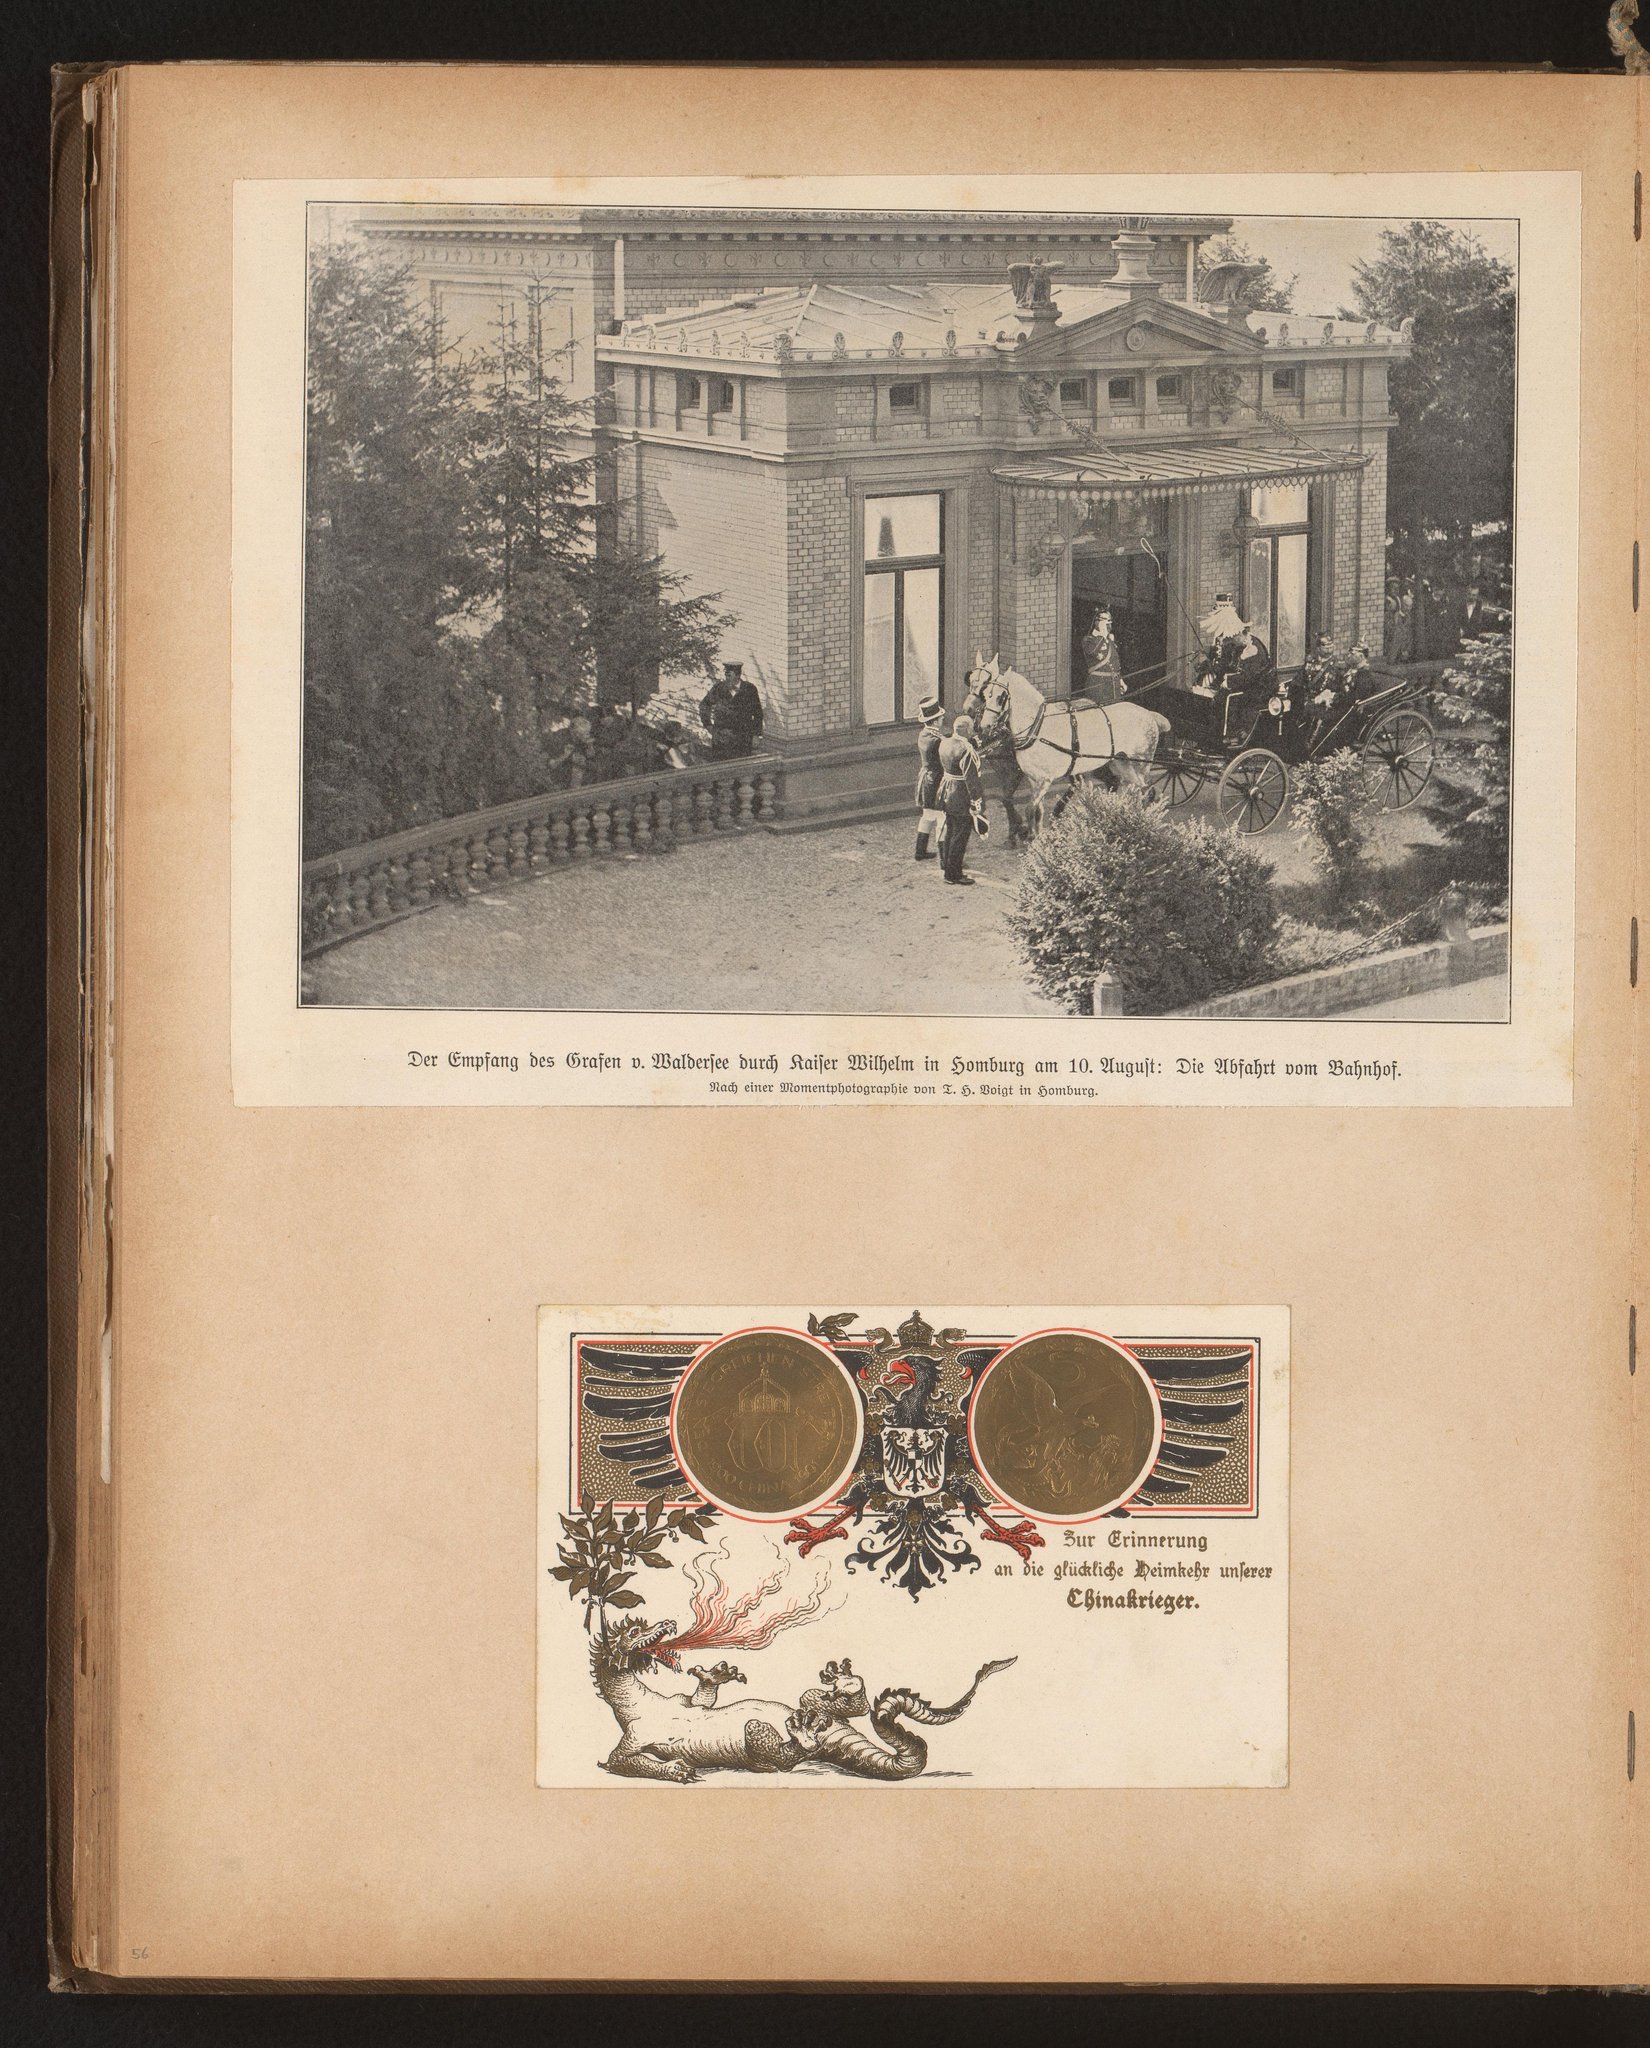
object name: ansichtkaart, prentbriefkaart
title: Rijtuig bij een paleis in Homburg en een prentbriefkaart ter herinnering aan de Bokseropstand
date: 1901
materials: cardboard, paper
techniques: blind stamped, lithograph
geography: homburg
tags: predatory birds: eagle, palace, dragon, four-wheeled vehicle drawn by two animals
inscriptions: inscription: ‘Der Empfang des Grafen v. Waldersee durch Kaiser Wilhelm in Homburg am 10. August: Die Abfahrt vom Bahnhof./ Nach einer Momentphotographie von T.H. Voigt in Homburg.’, inscription: ‘Zur Erinnerung/ an die glückliche Heimkehr unserer/ Chinakrieger.’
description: Deze fotomechanische afdruk en prentbriefkaart maken deel uit van een album.